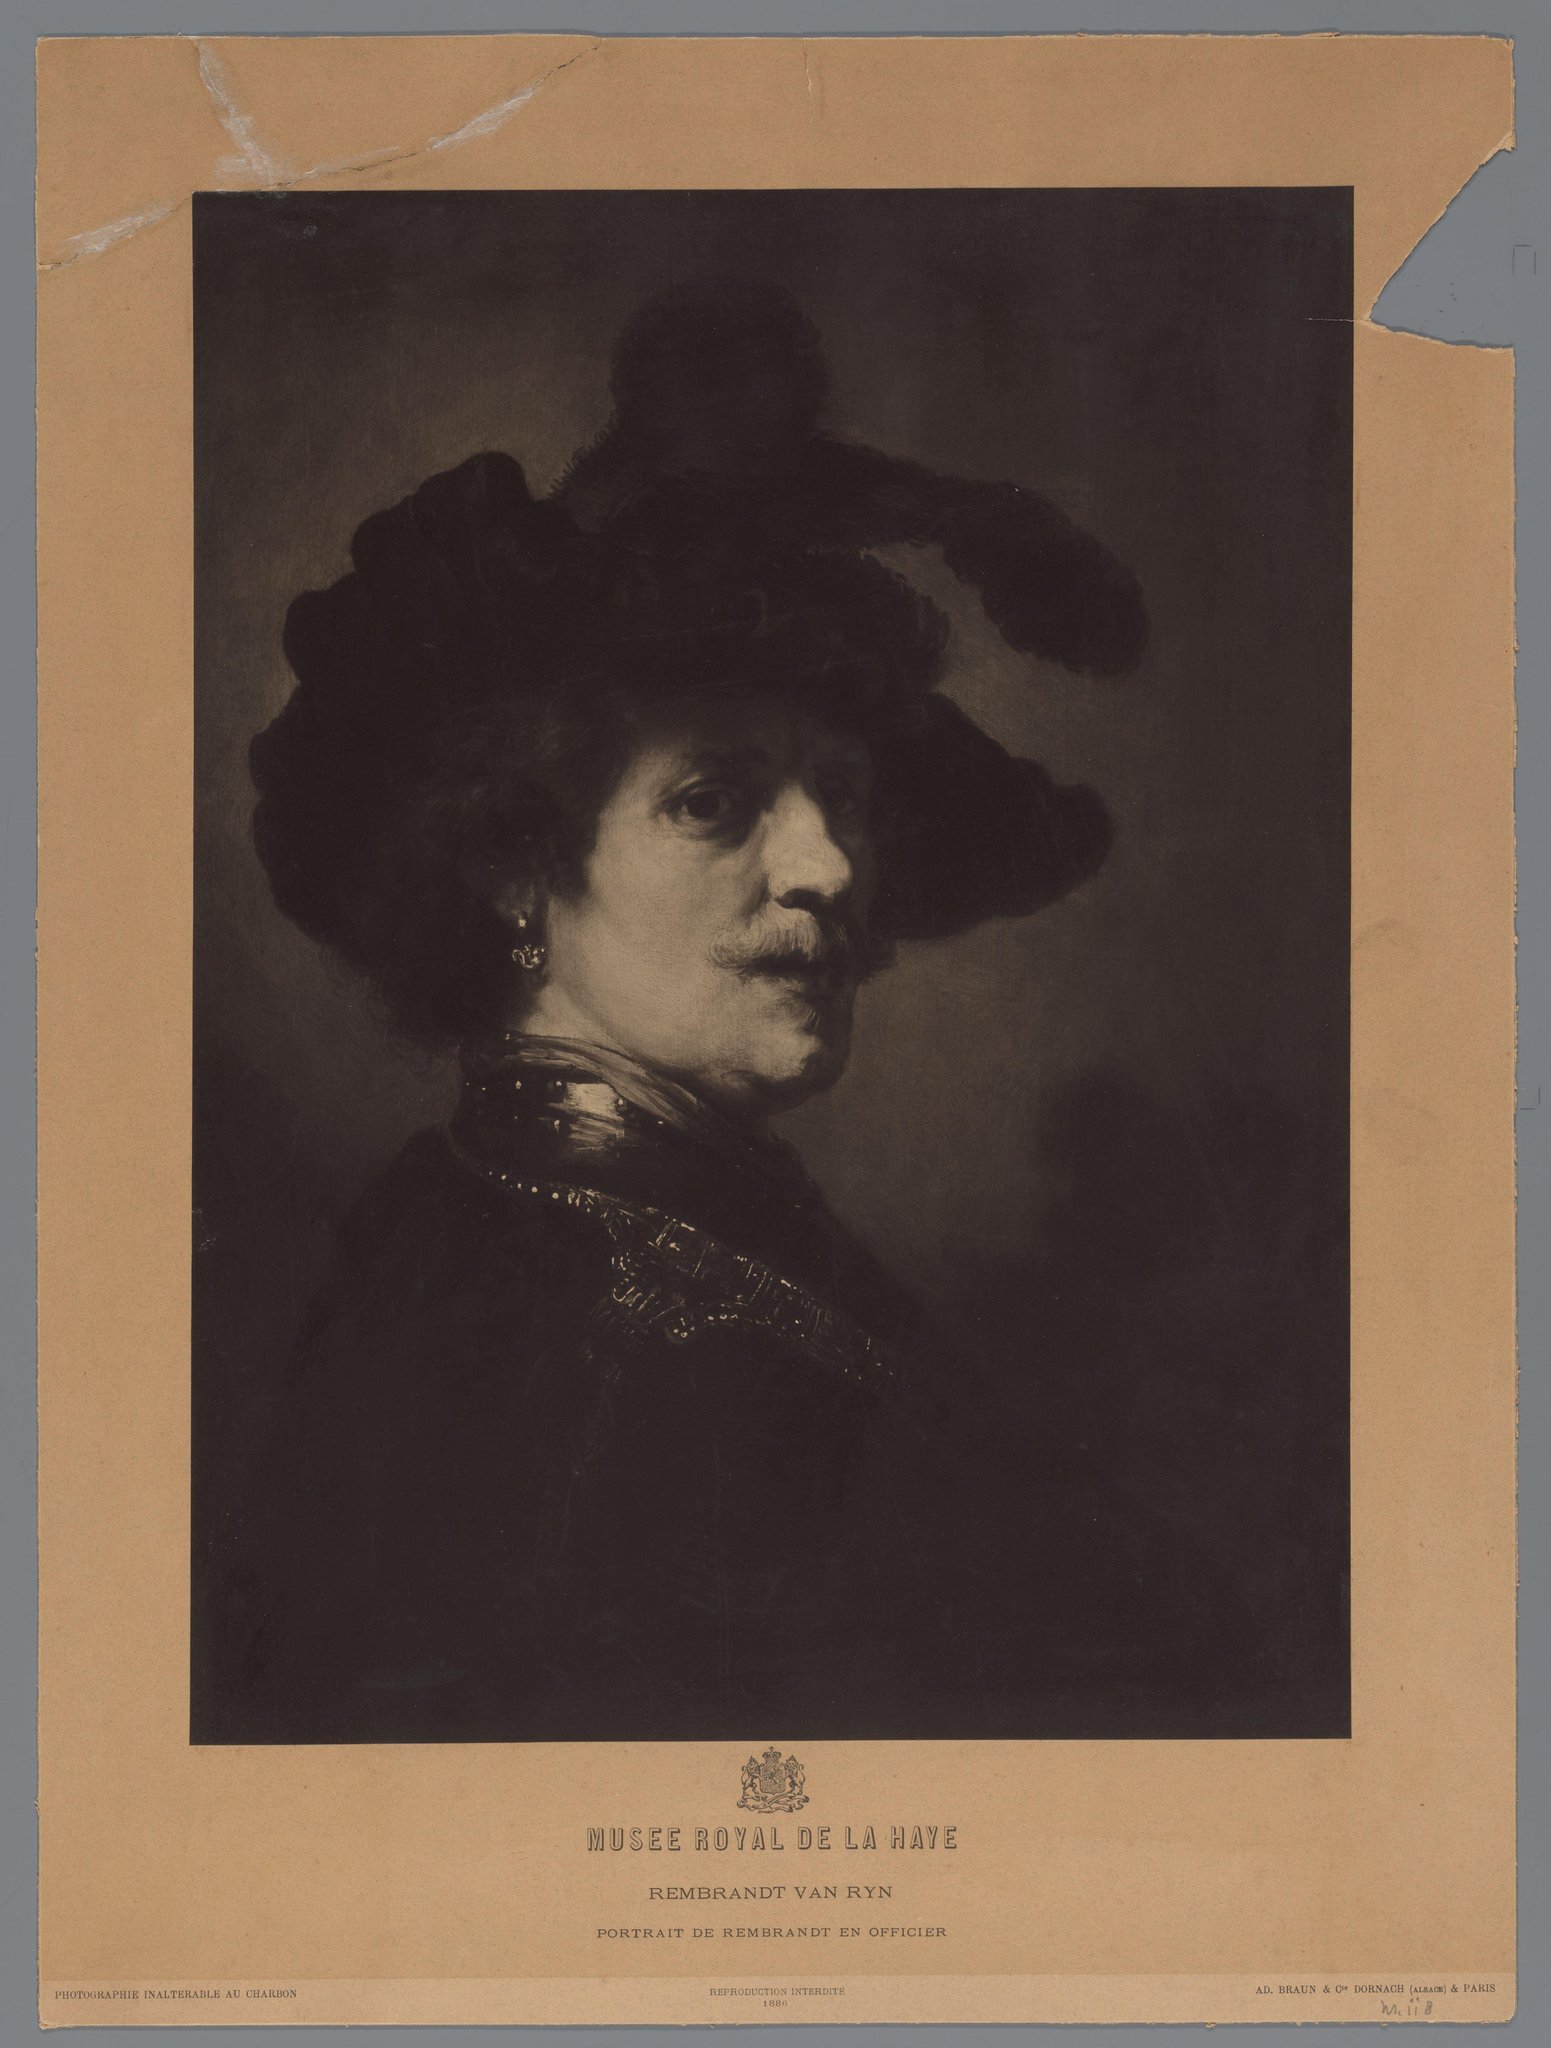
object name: photograph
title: Fotoreproductie van een schilderij van Rembrandt, 'Zelfportret' (coll. Mauritshuis)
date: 1886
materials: cardboard, paper, photographic support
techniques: carbon print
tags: amsterdam, painter, print maker, draughtsman, rembrandt van rijn